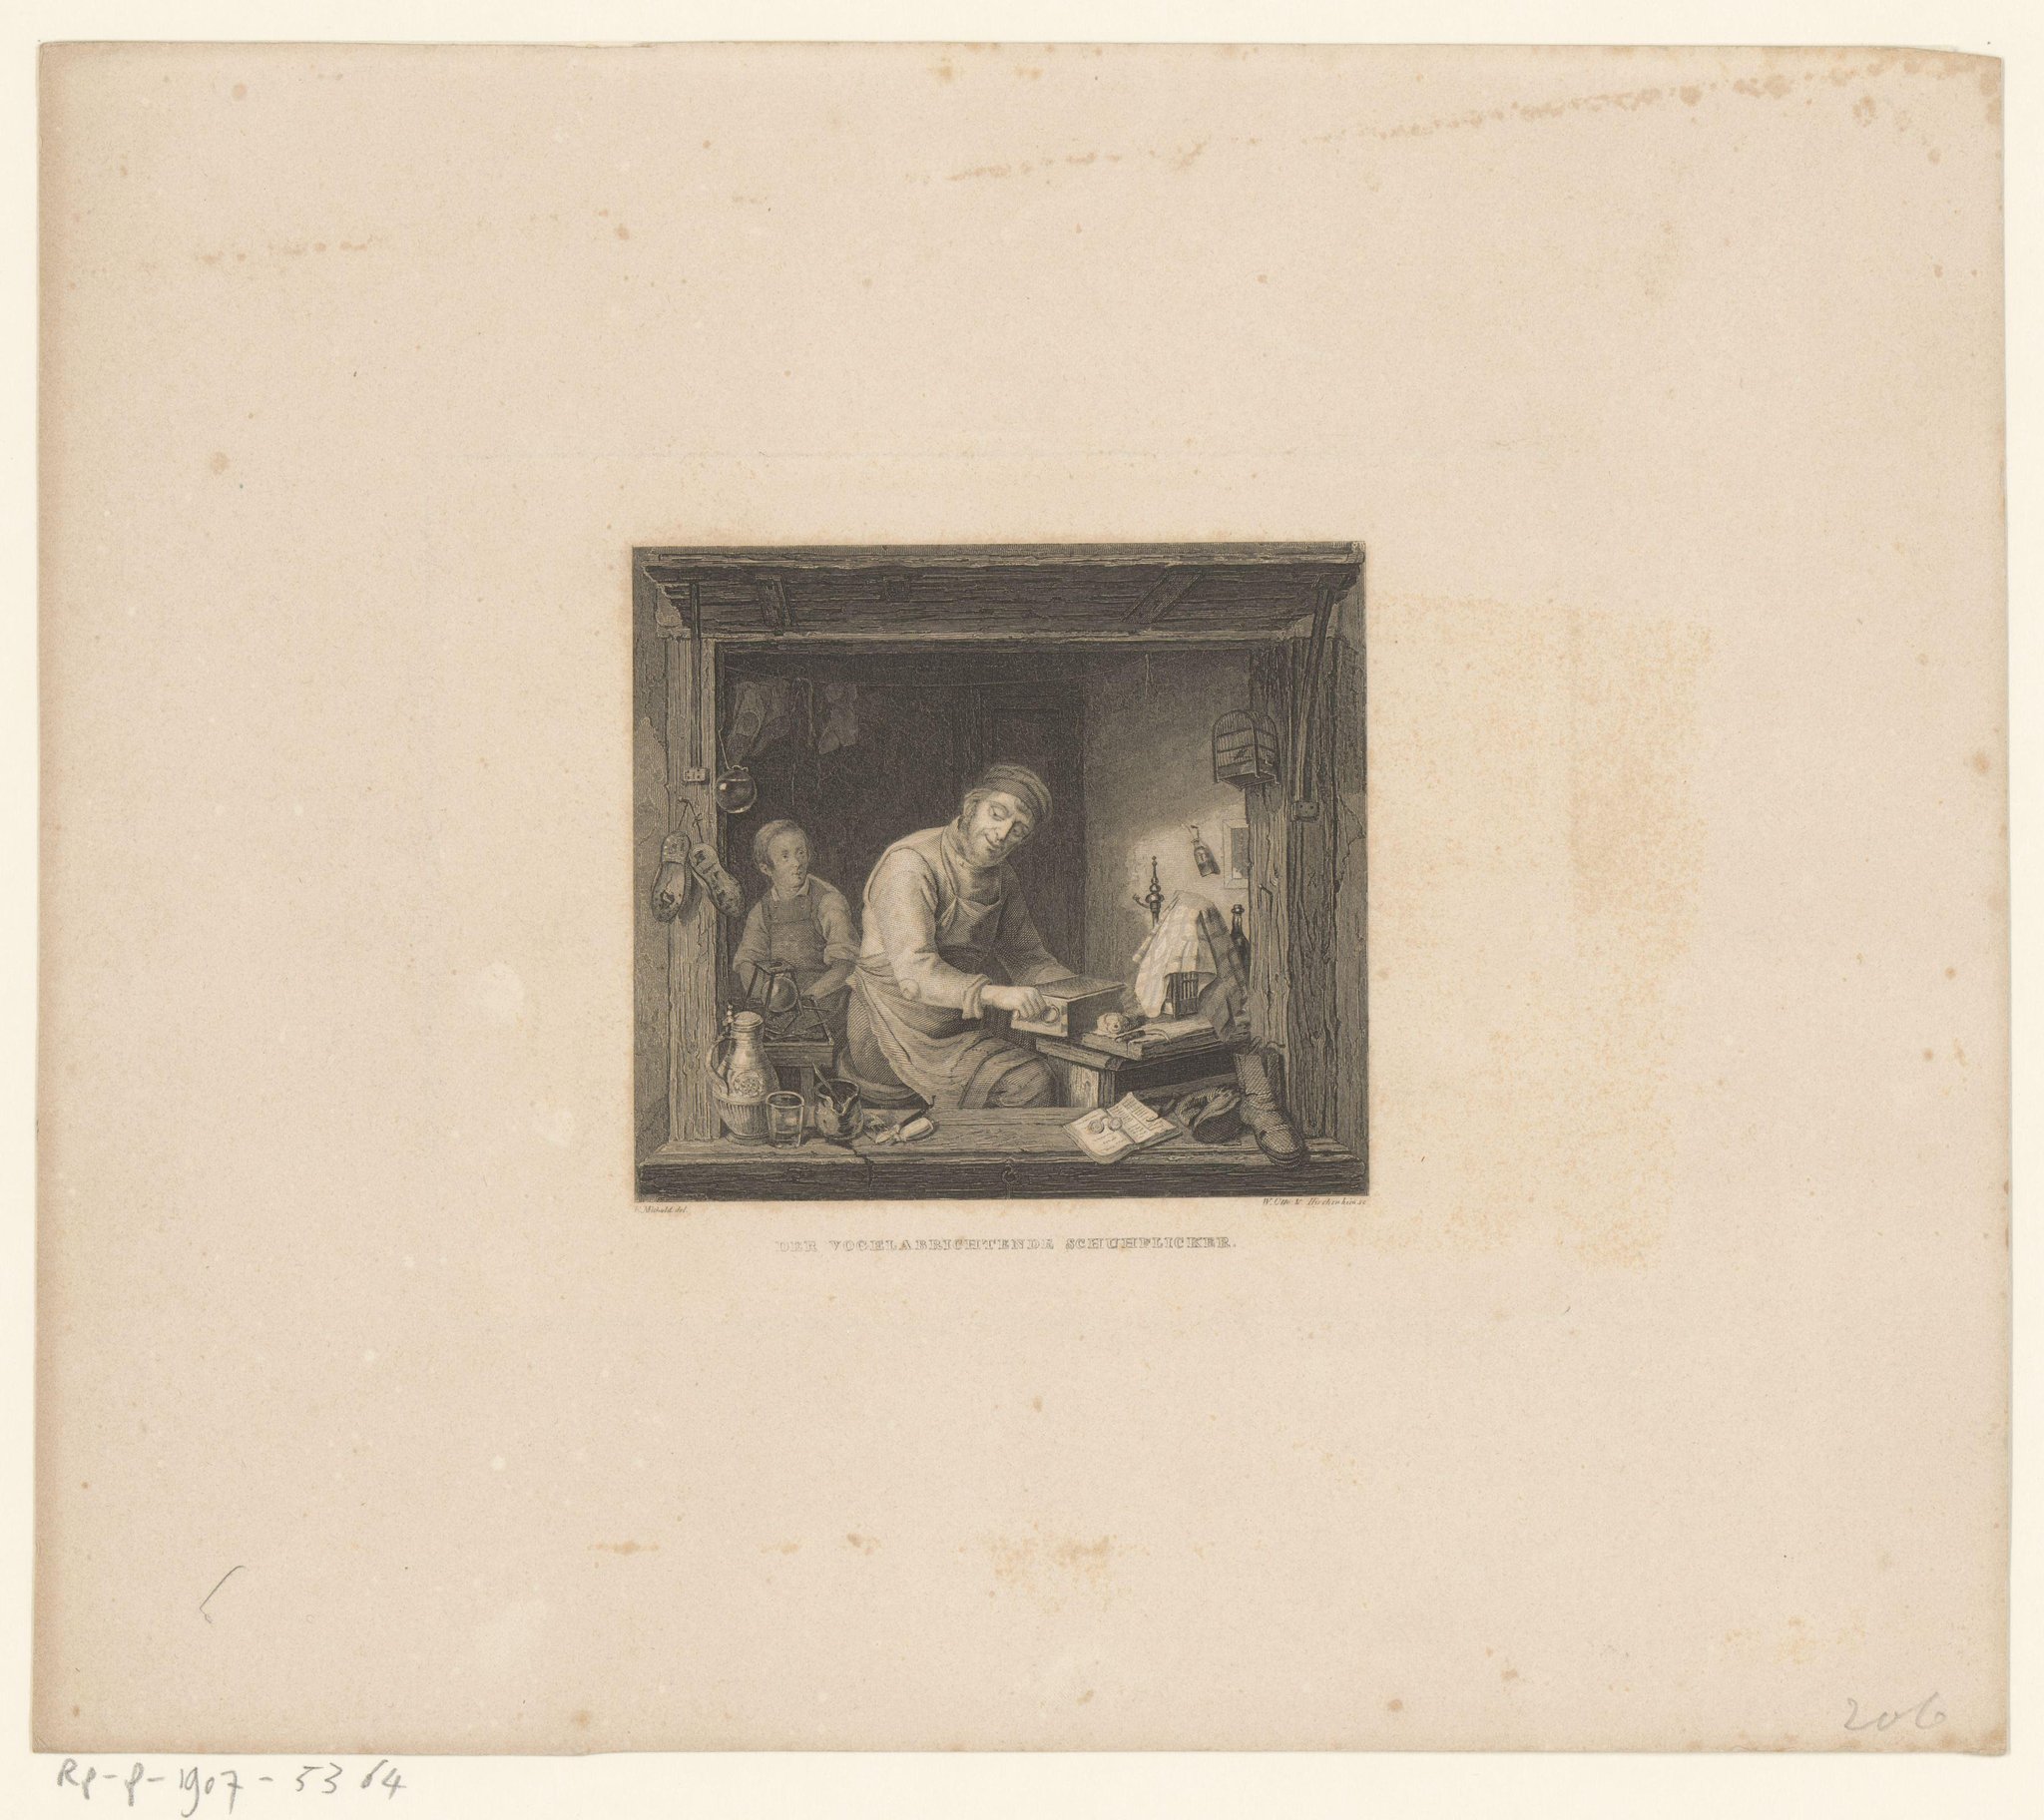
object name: print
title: Schoenmaker aan het werk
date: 1800-1899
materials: paper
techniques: engraving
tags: shoe-maker, cobbler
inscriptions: collector's mark: Lugt 2228